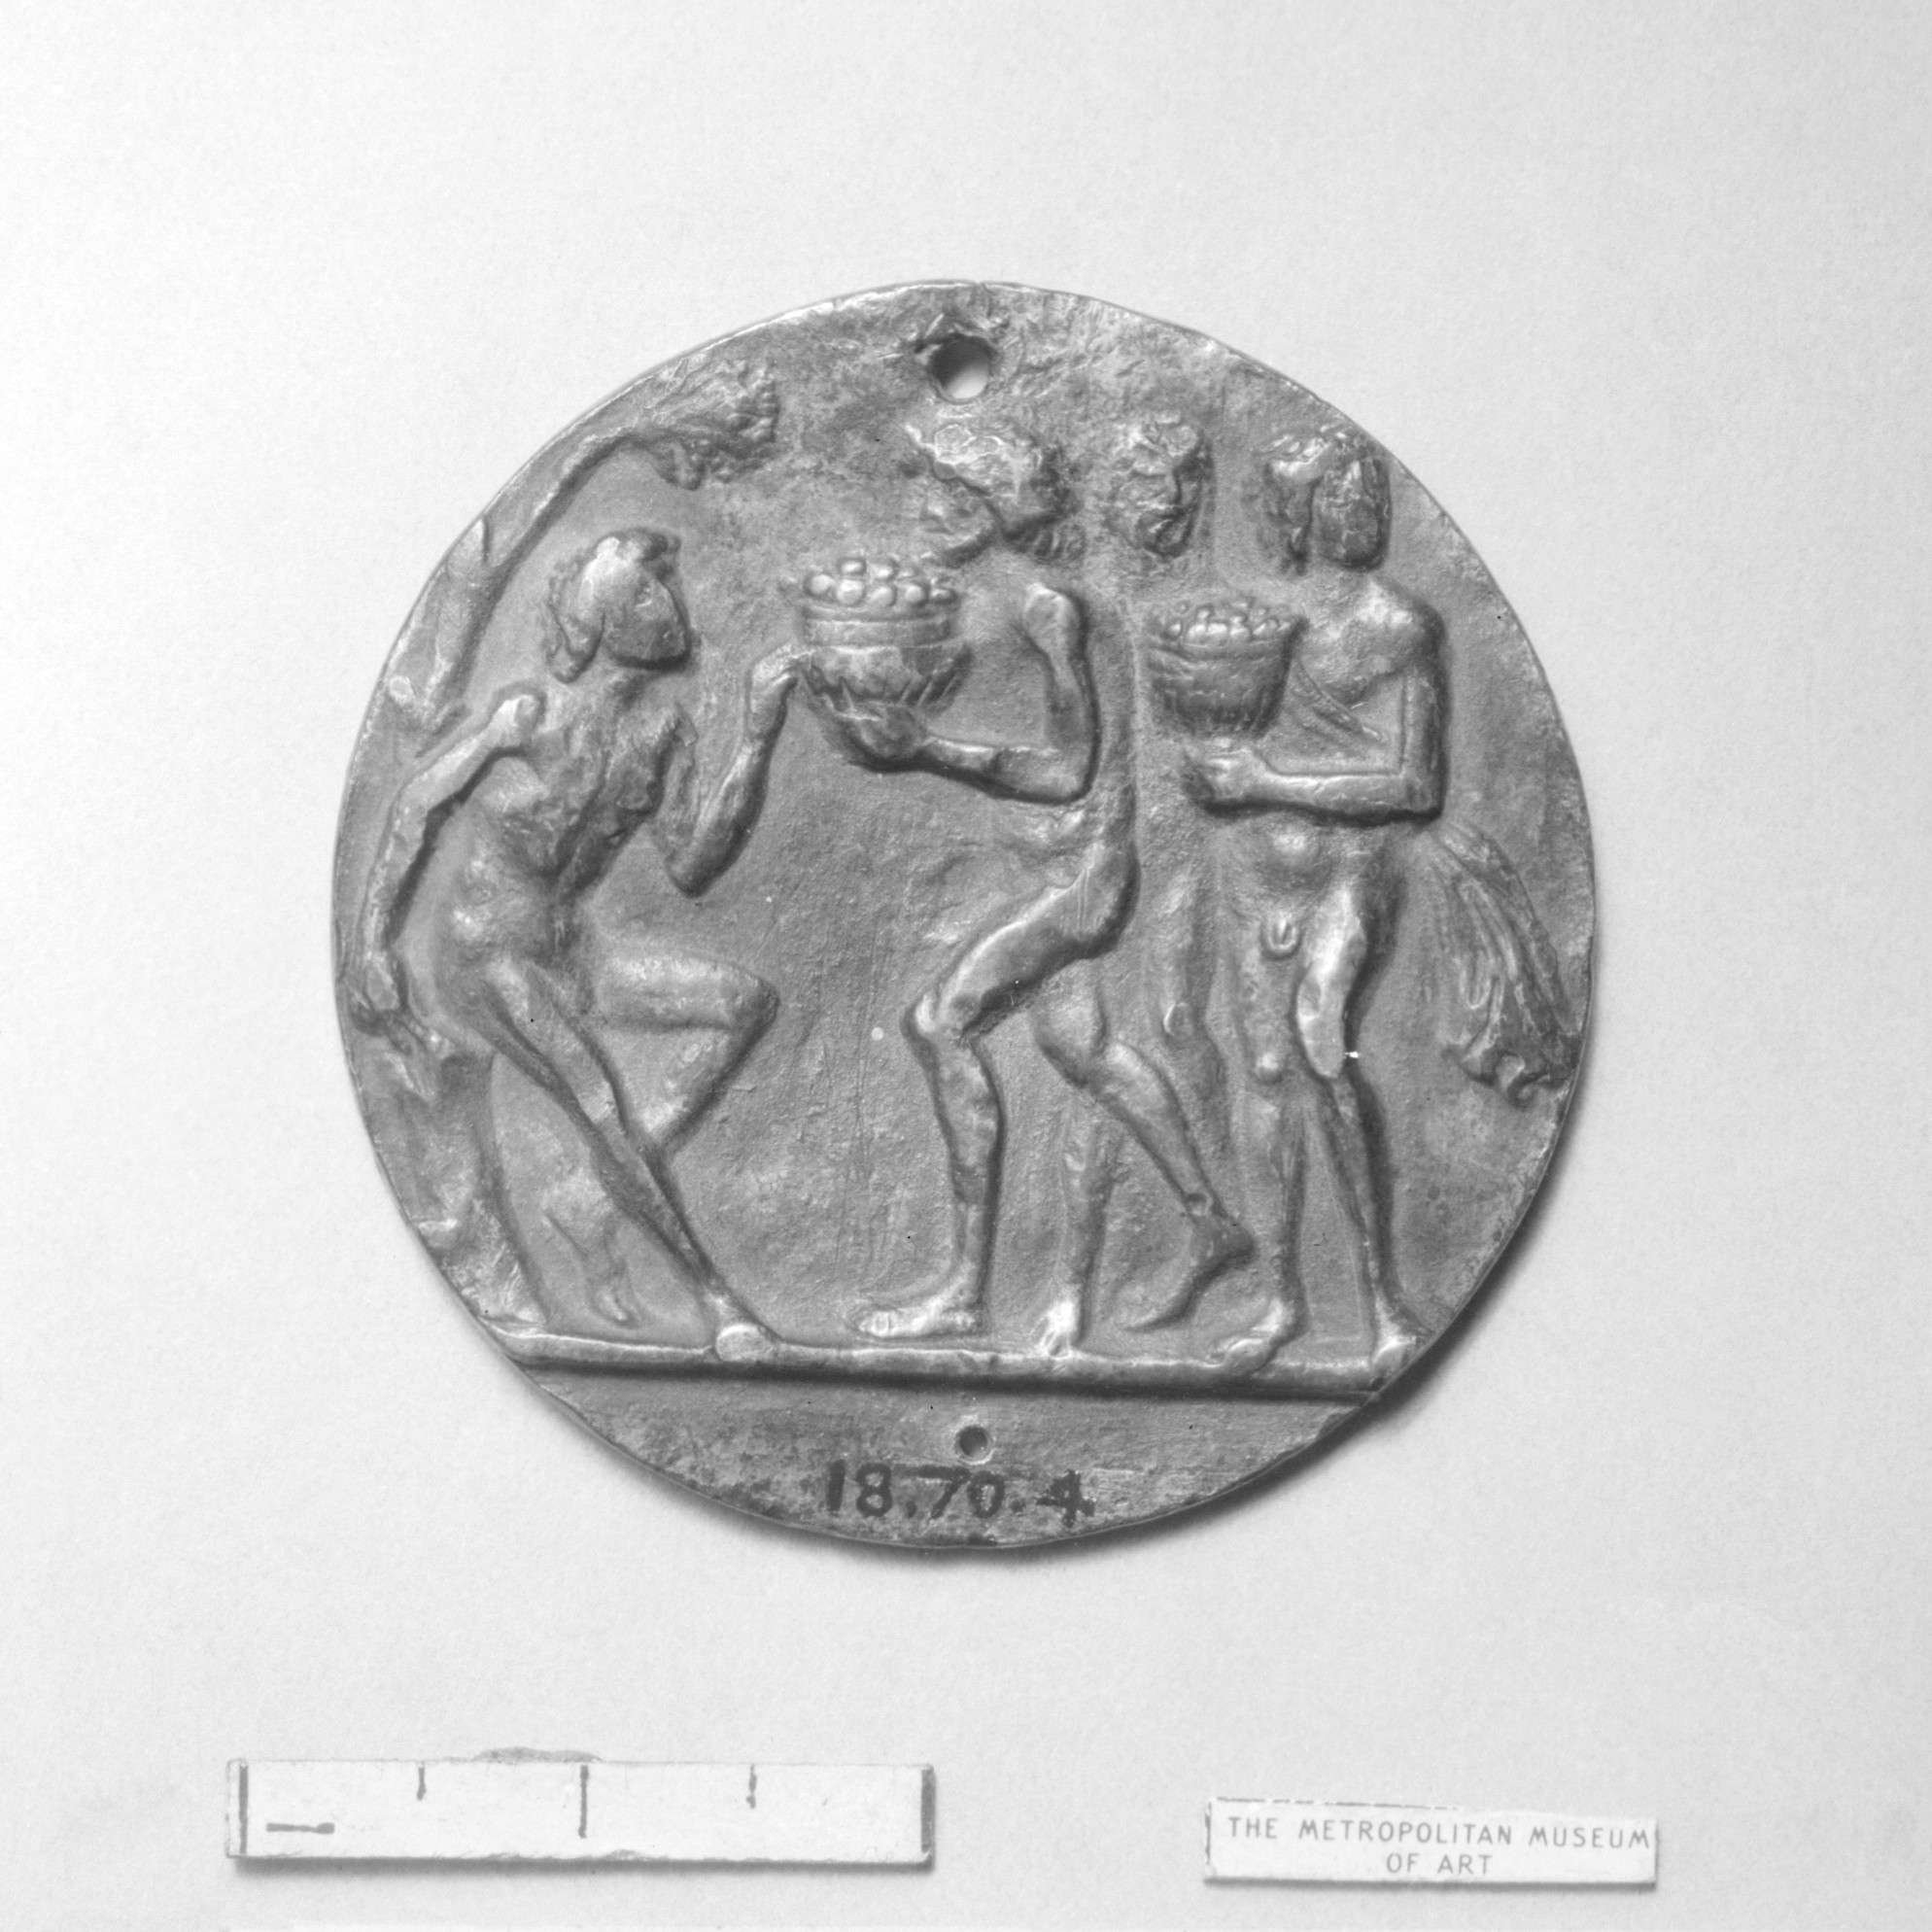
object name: plaquette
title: Offering scene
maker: pseudo-melioli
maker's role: maker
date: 1501-1533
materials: bronze, gilt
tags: male nudes